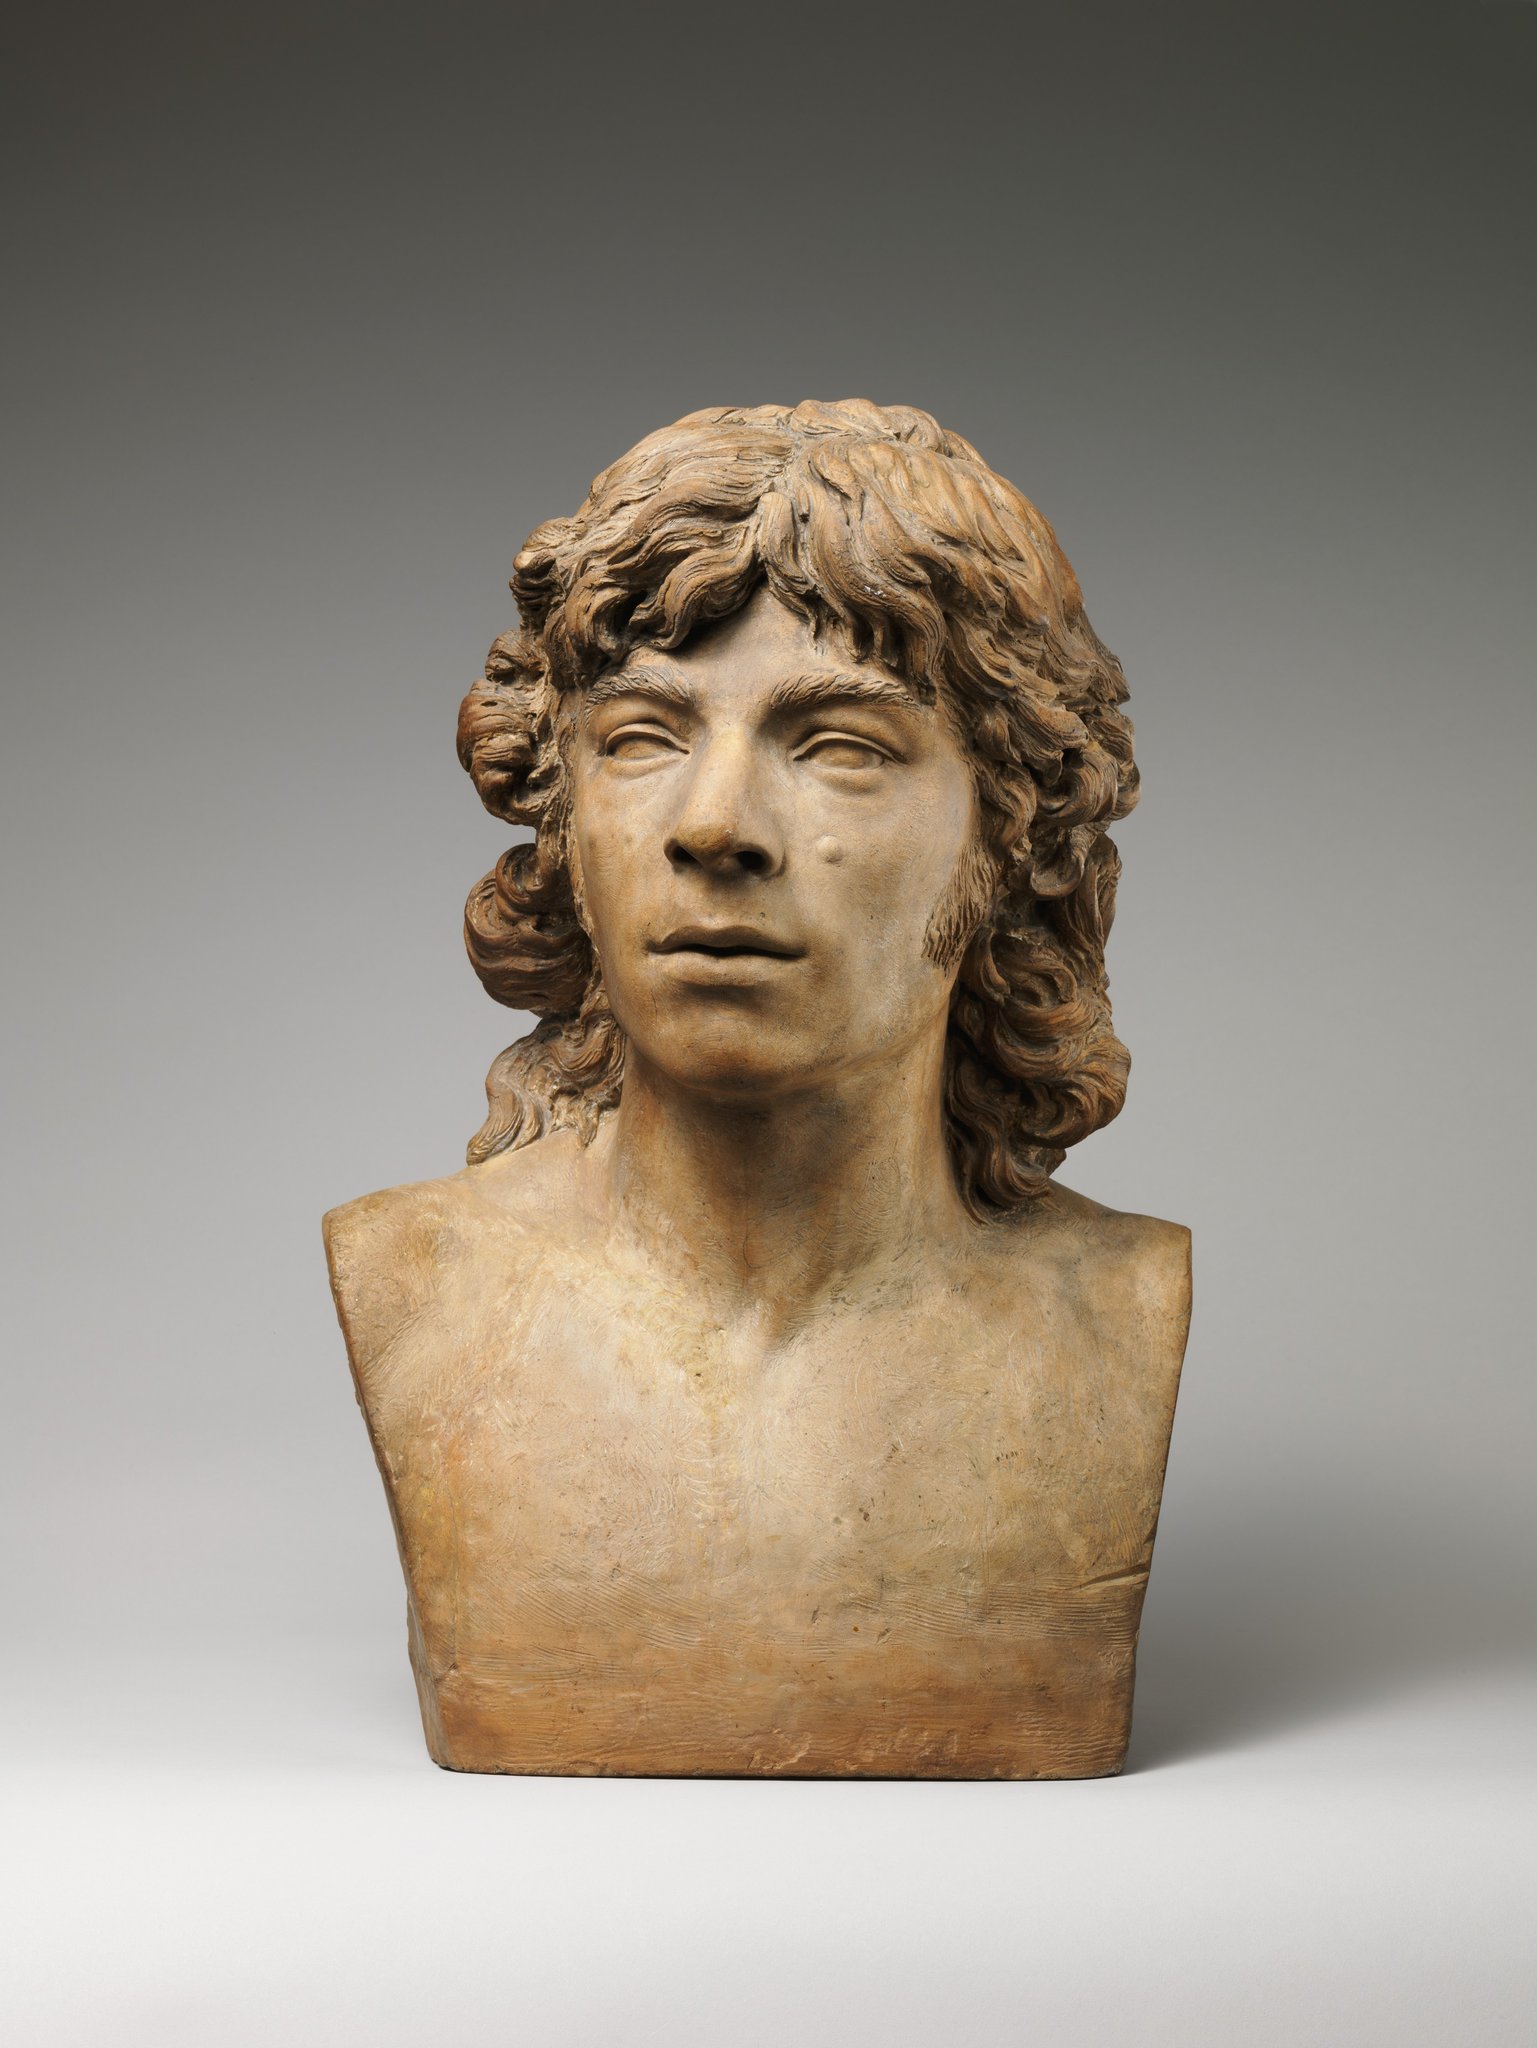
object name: bust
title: Presumed portrait of Jacques-René Hébert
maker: joseph chinard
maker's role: artist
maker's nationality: french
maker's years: 1756-1813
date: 1790-1795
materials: terracotta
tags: men